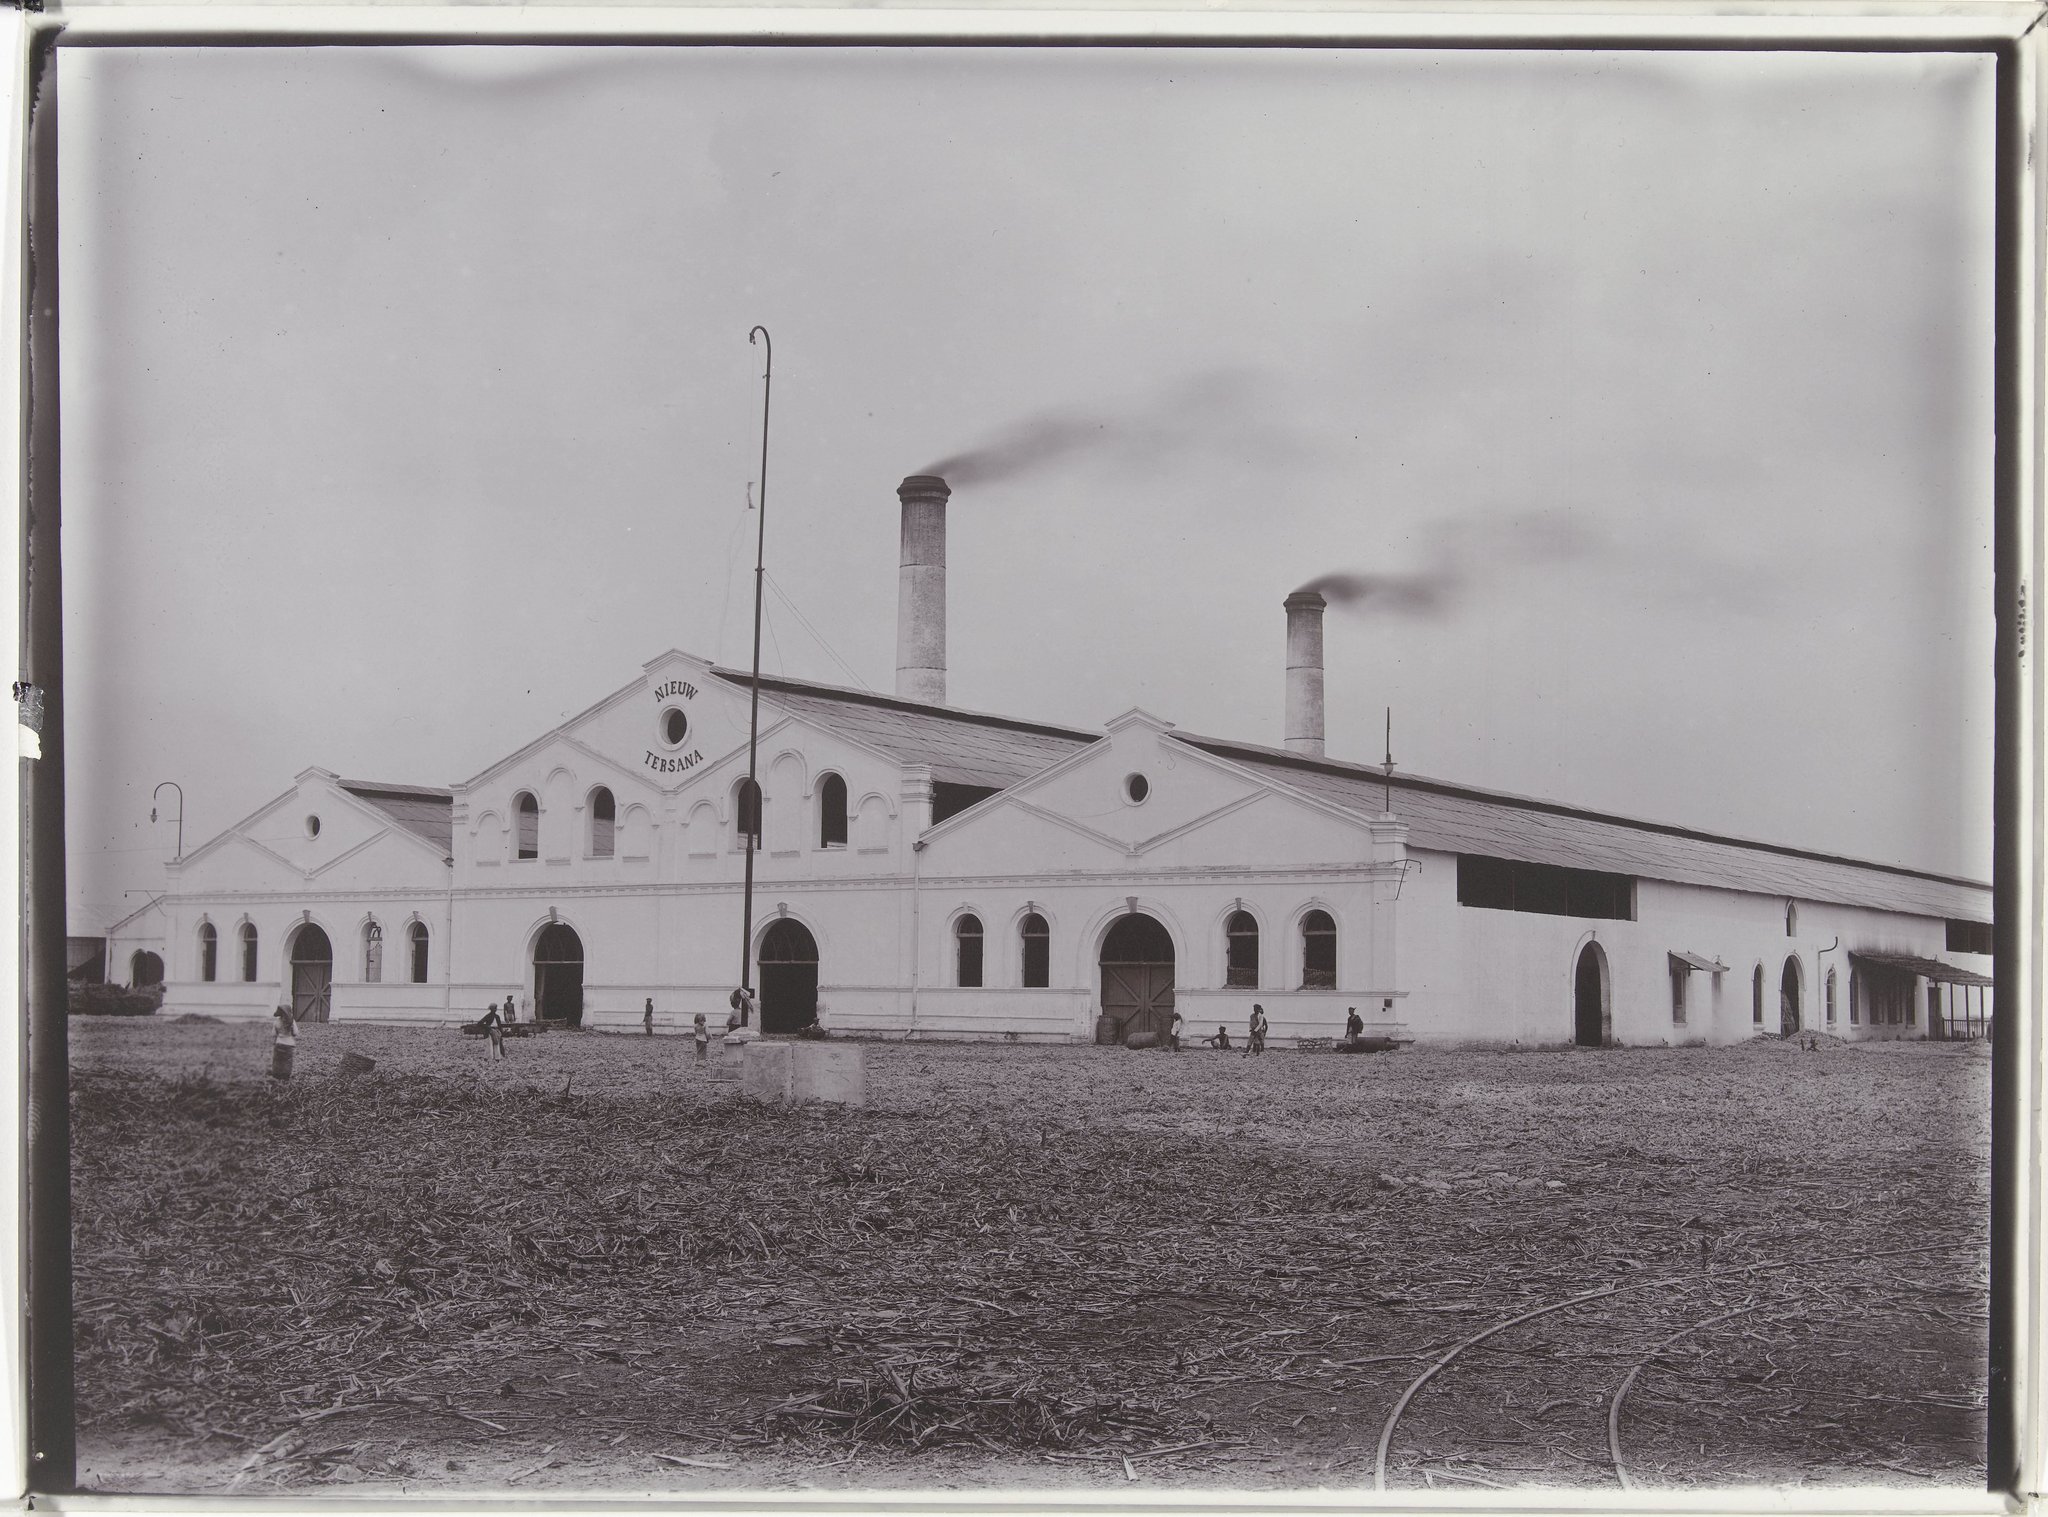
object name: photograph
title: Suikerfabriek Nieuw Tersana in Tersana, voormalig Nederlands-Indië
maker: onnes kurkdjian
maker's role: fotograaf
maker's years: 1851-1903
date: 1890-1911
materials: paper, photographic support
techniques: gelatin silver print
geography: cirebon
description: Suikerfabriek Nieuw Tersana in Tersana (Cirebon), voormalig Nederlands-Indië.